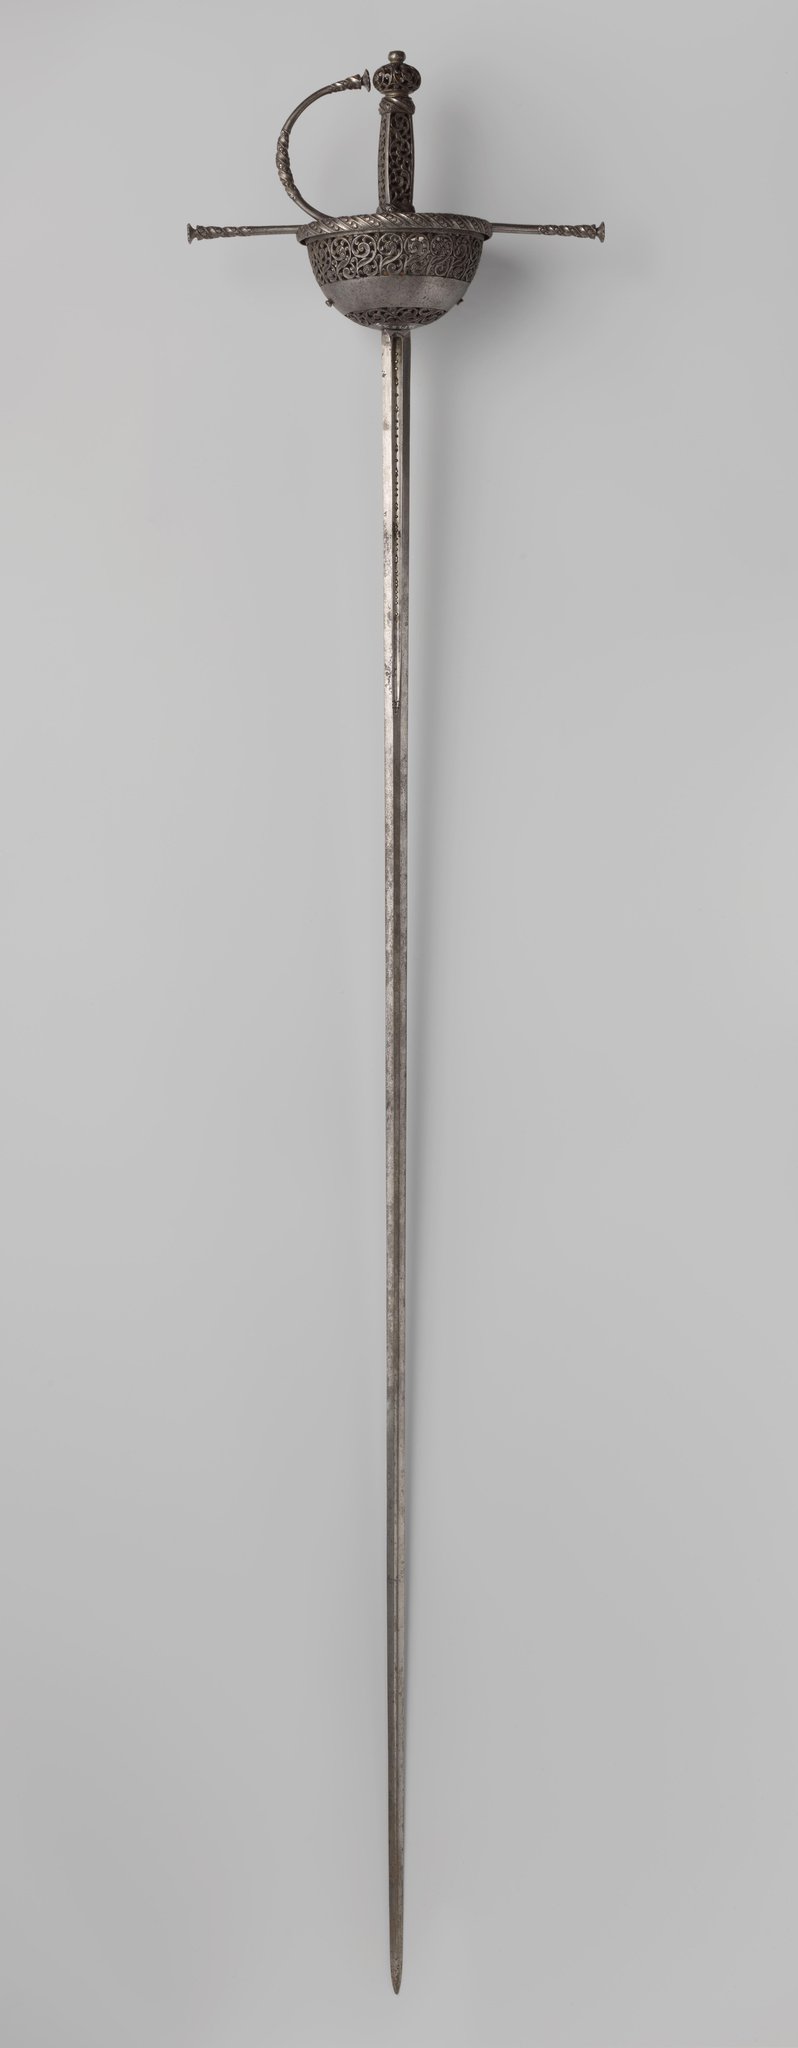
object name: rapier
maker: Anonymous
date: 1500-1600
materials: iron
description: Rapier met lange smalle kling, aan de zijden afgeplat met opgengewerkte groef. Het gevest is voorzien van een lange rechte pareerstang. Aan de uiteinden getordeerd en met bladornamenten versierd. Een enkele stoogbeugel eender versierd en dito greep en knop van sierlijk gesmeed ijzer. Opengewerkte stootkom. Spaans model, 1e helft 17de eeuw.